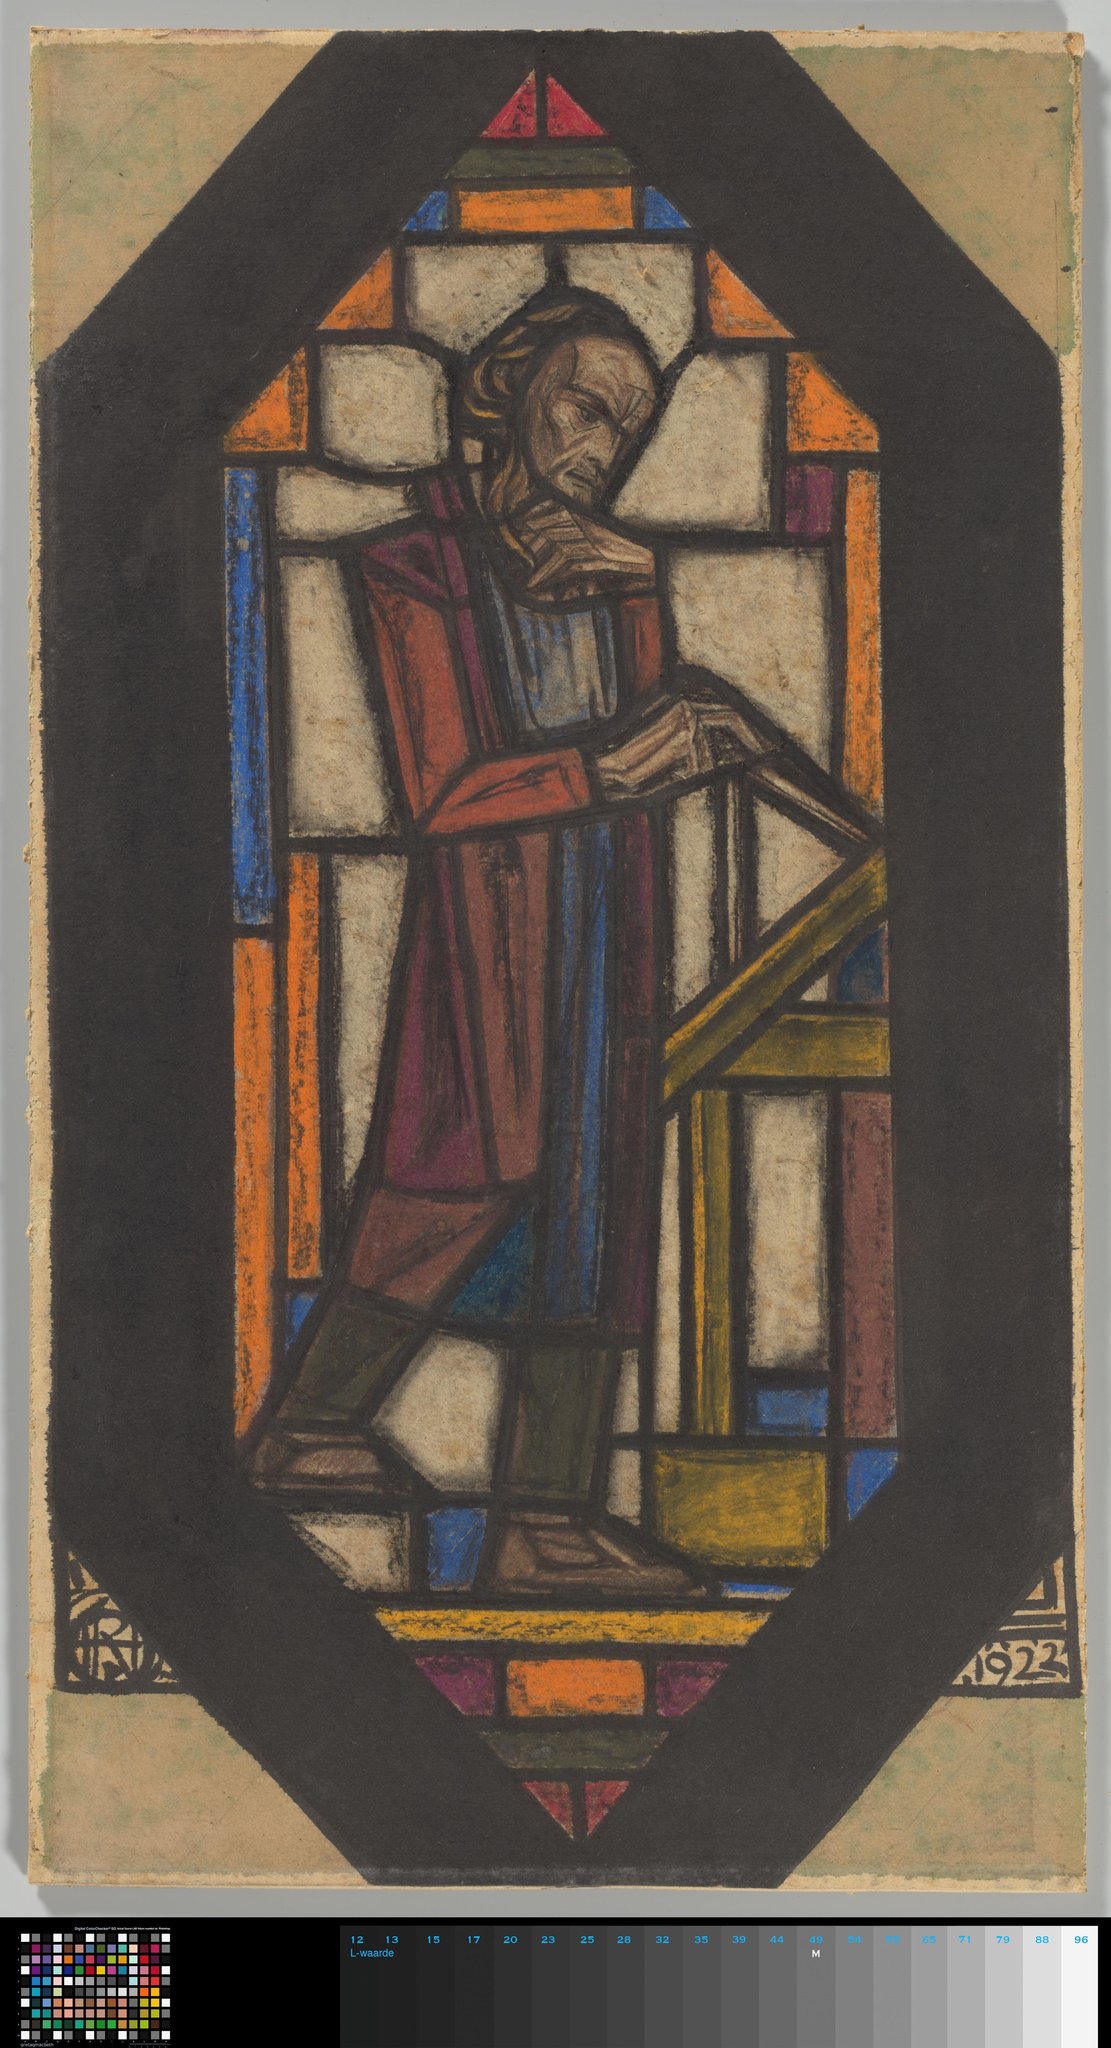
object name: drawing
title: Ontwerp voor raam in het postkantoor te Haarlem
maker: richard nicolaüs roland holst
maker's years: 1868-1938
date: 1922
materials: cardboard, chalk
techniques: brush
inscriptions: monogram: ‘RNRH’